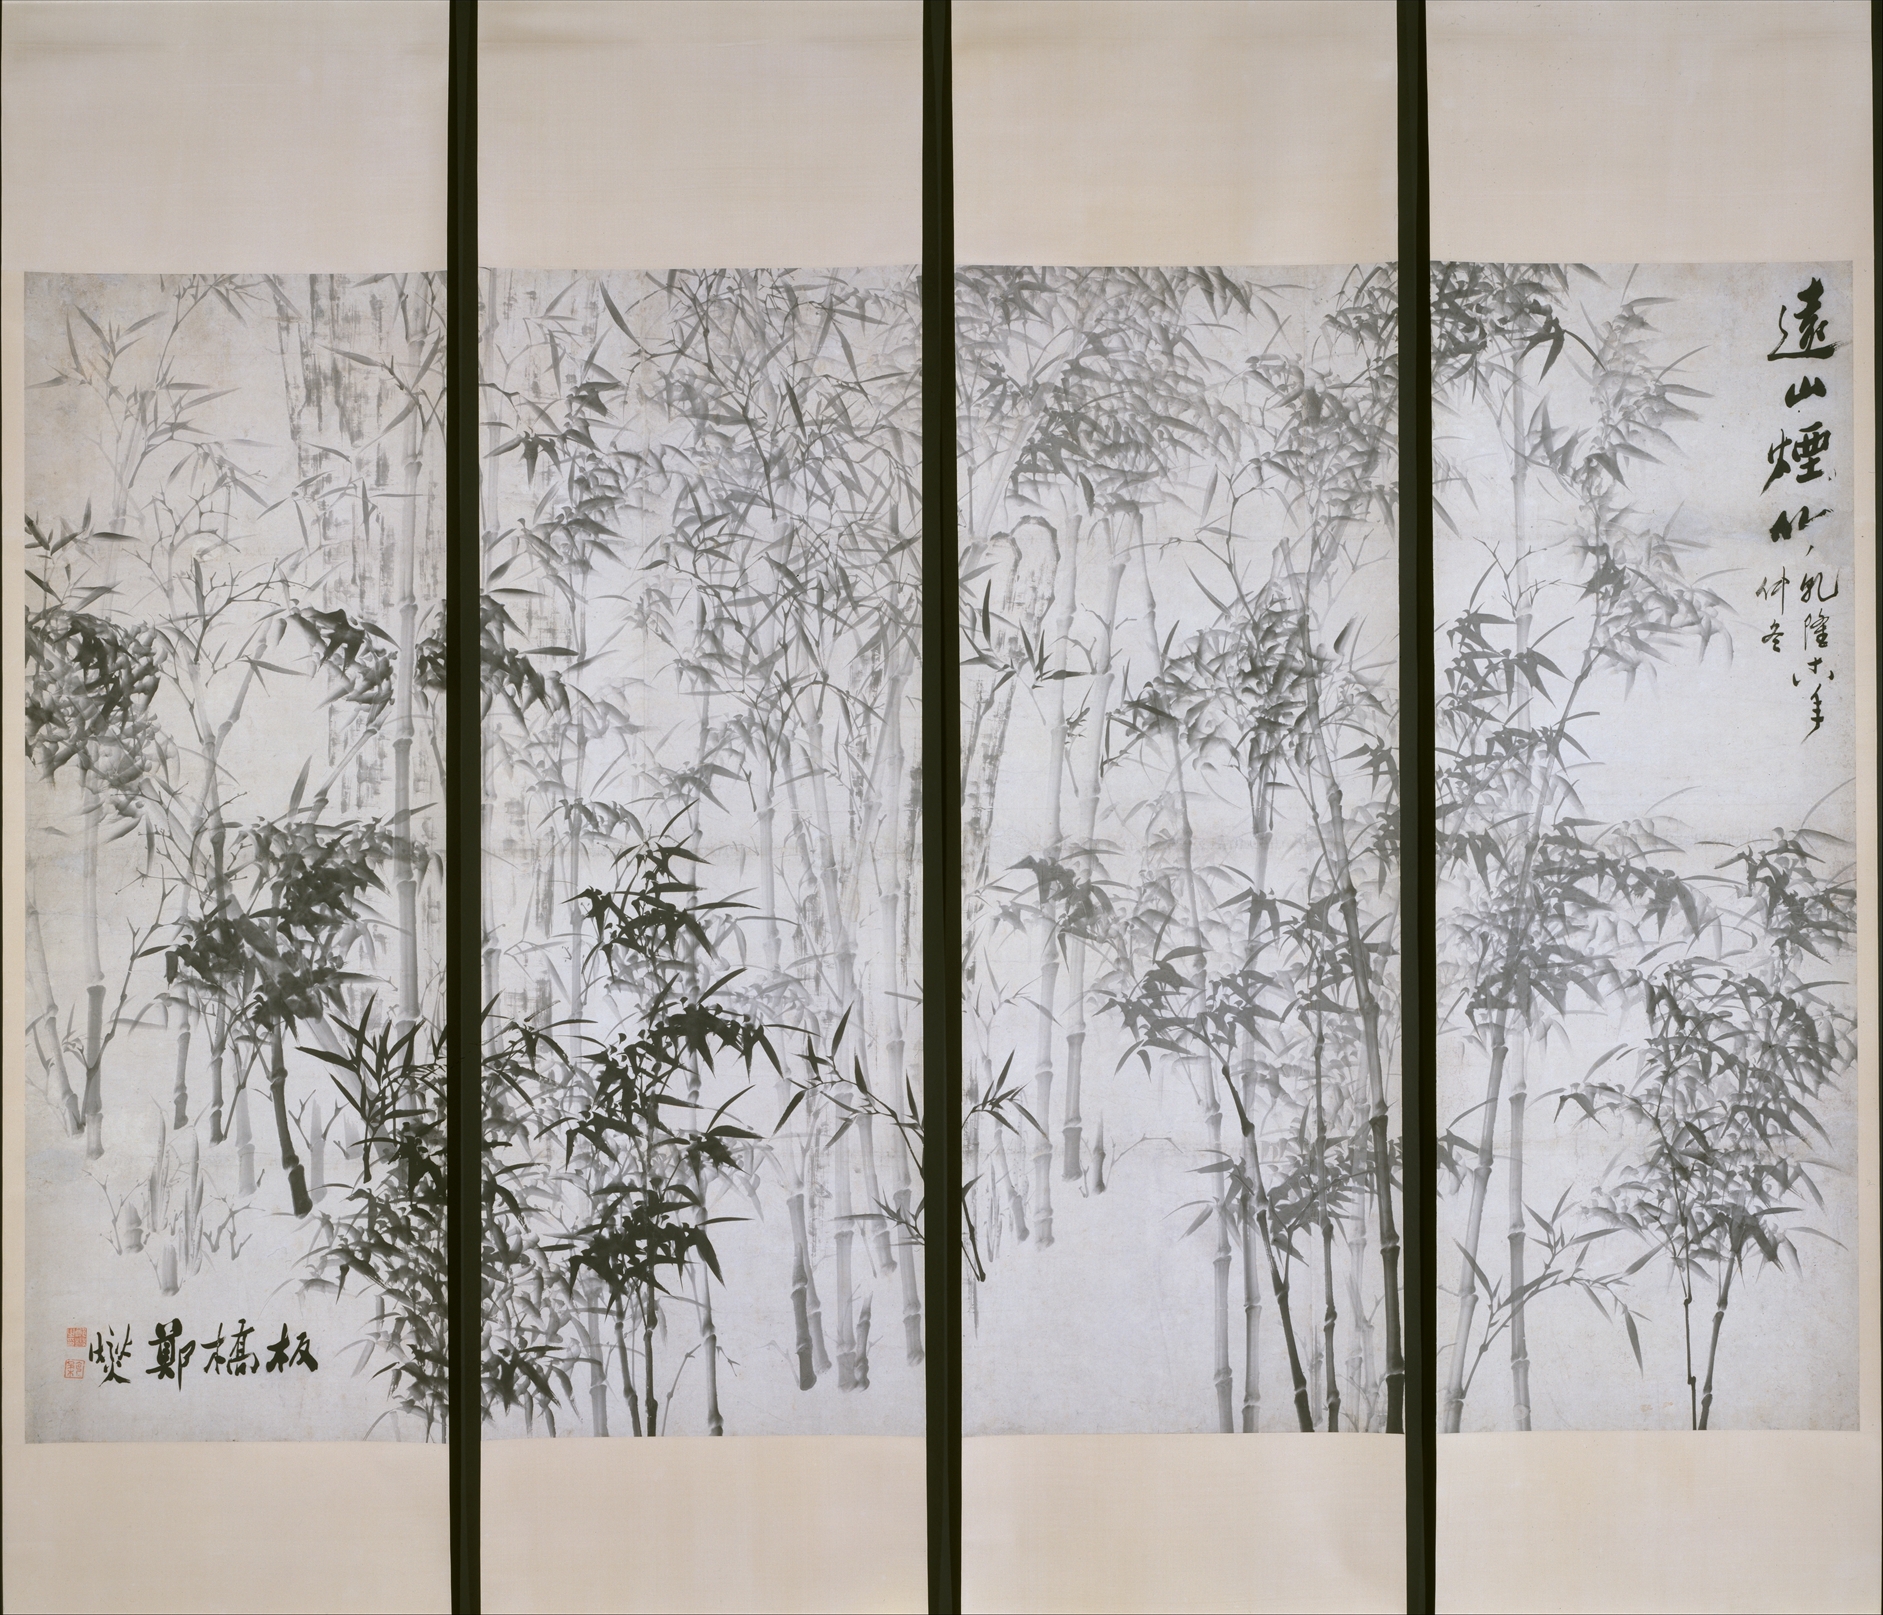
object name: hanging scroll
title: Misty Bamboo on a Distant Mountain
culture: chinese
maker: zheng xie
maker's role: artist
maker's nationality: chinese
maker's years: 1693-1765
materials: ink, paper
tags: bamboo